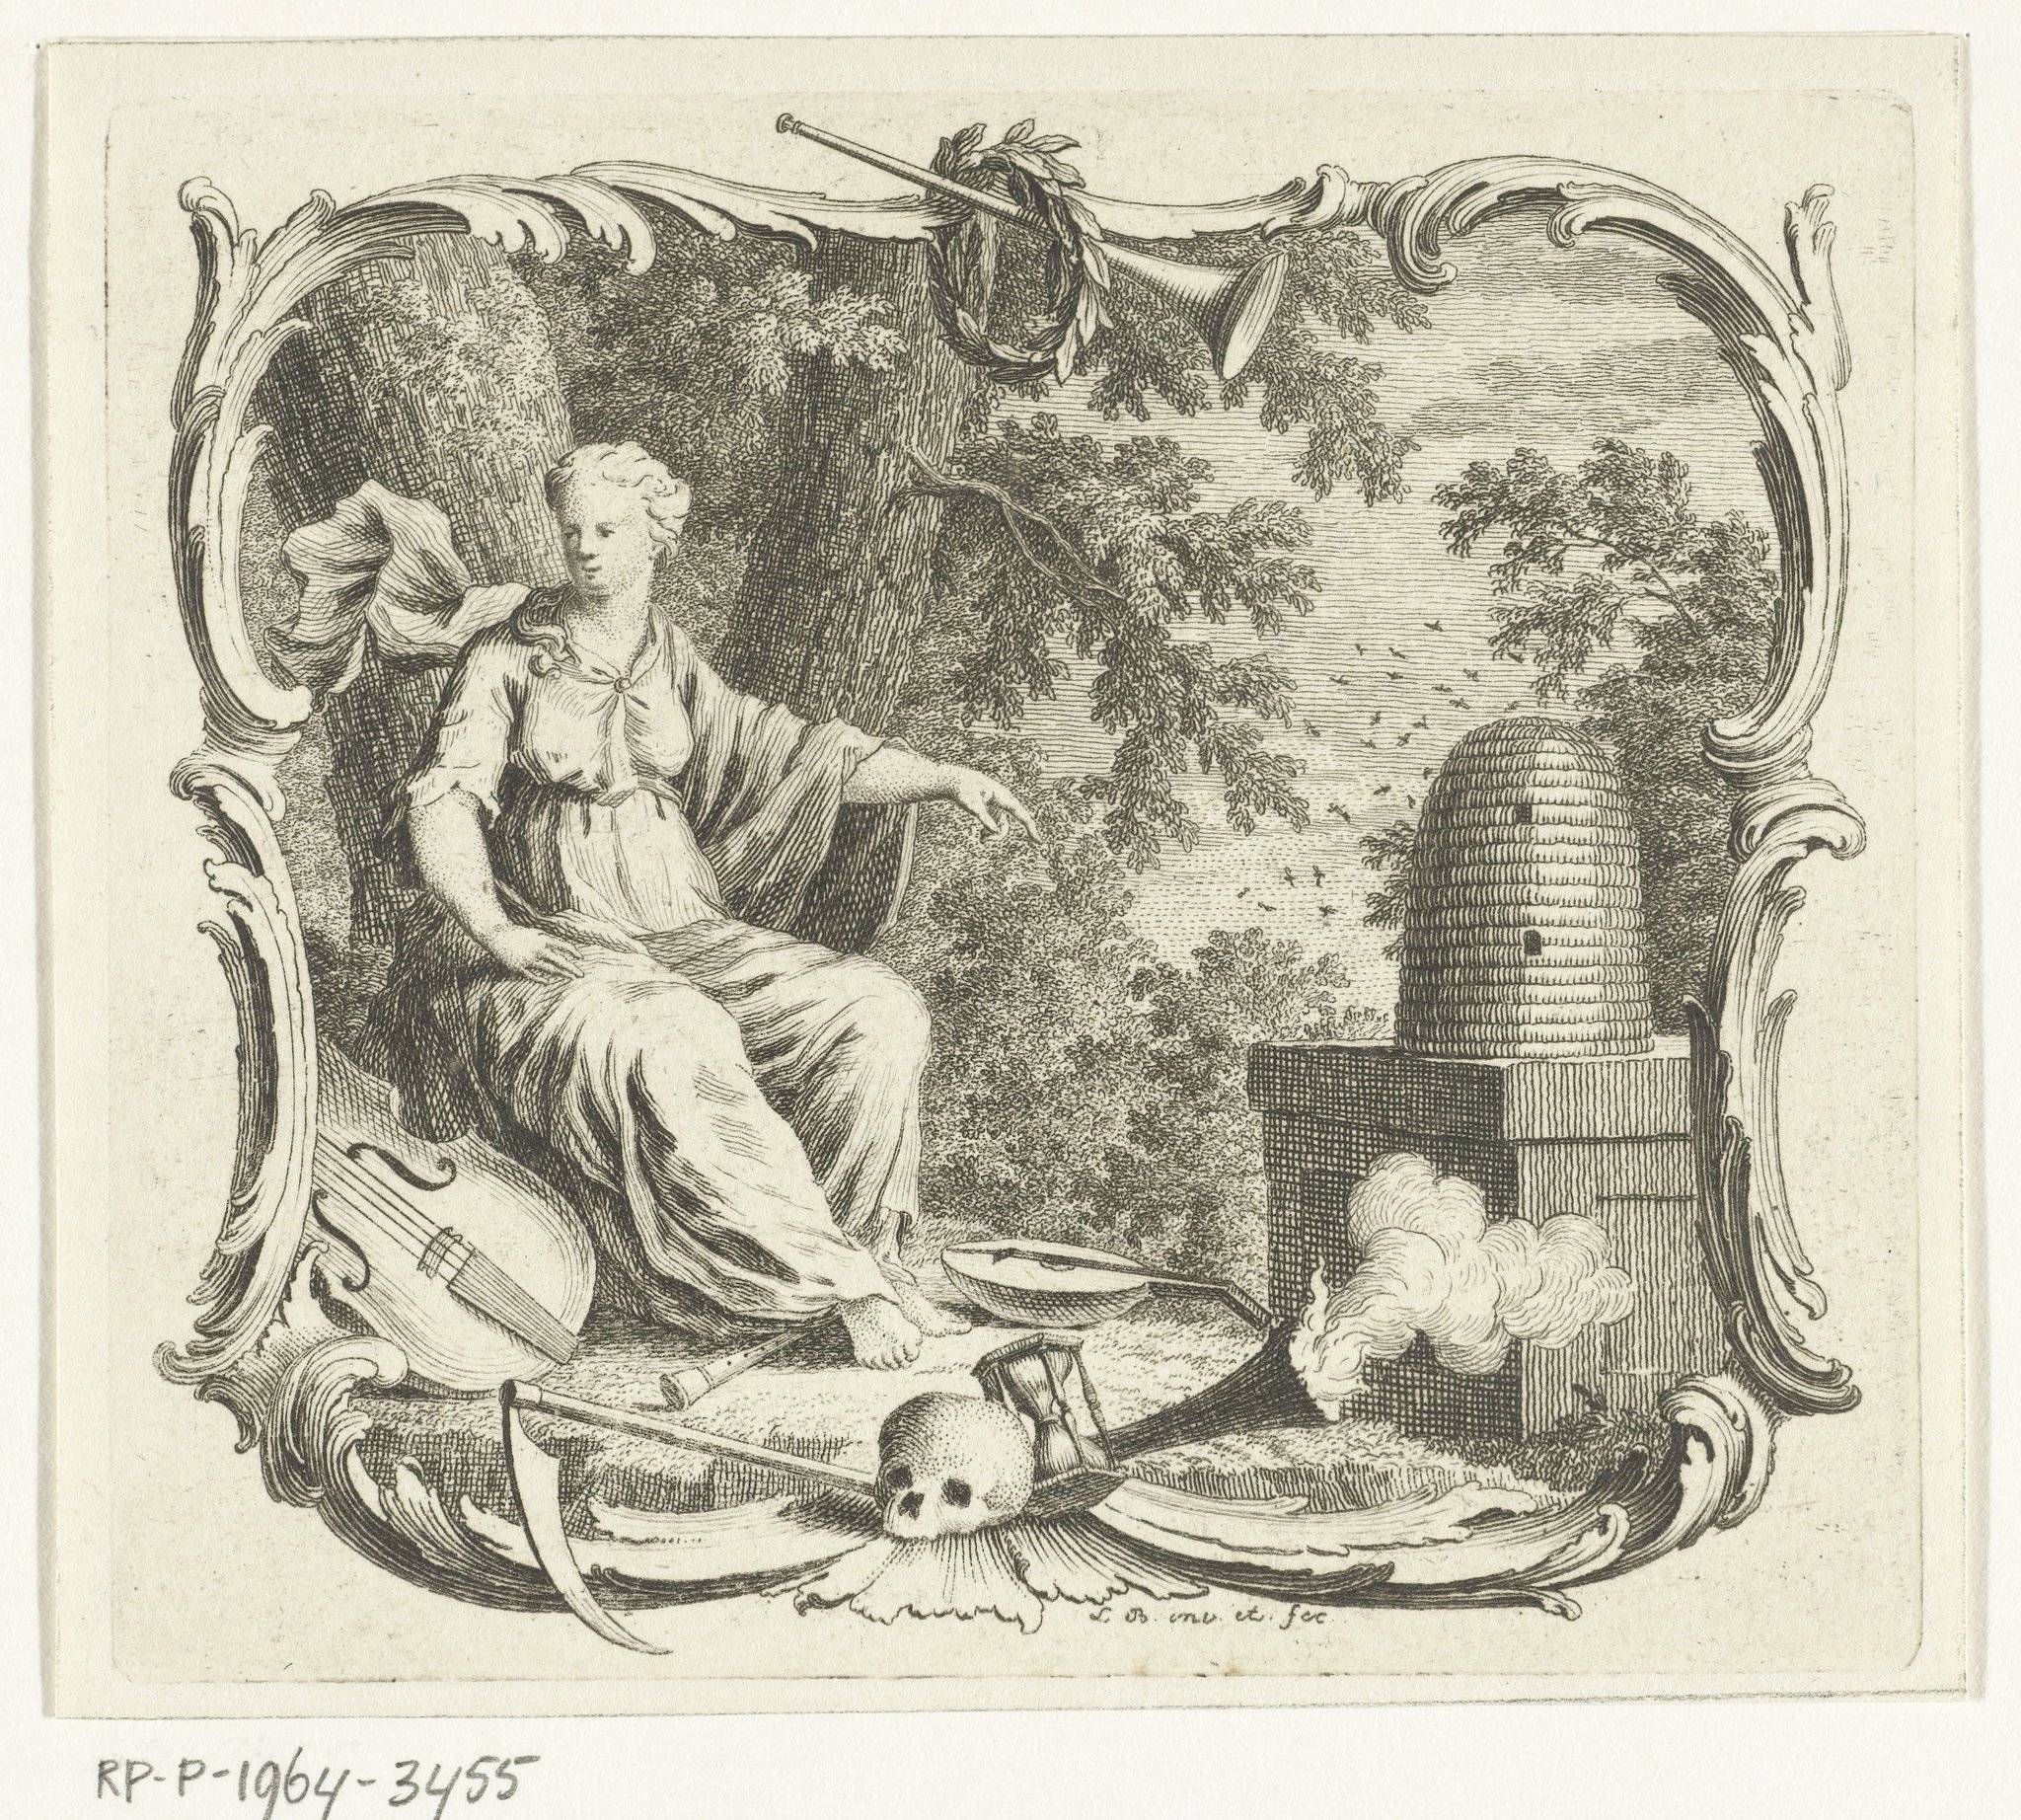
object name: print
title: Vignet met allegorie met symbolen van overvloed en vergankelijkheid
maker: leendert brasser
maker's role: draughtsman, print maker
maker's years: 1727-1793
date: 1727-1793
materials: paper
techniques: etching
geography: netherlands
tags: 'vanitas' symbols, bee-hive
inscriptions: collector's mark: Lugt 2228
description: Vignet met allegorie op overvloed en vergankelijkheid. Een vrouwelijke personificatie met verschillende muziekinstrumenten wijst naar een bijenkorf waar bijen omheen zwermen. In de omlijsting met krullende bladornamenten zijn symbolen van vergankelijkheid opgenomen: schedel, zandloper, zeis en brandende fakkel.